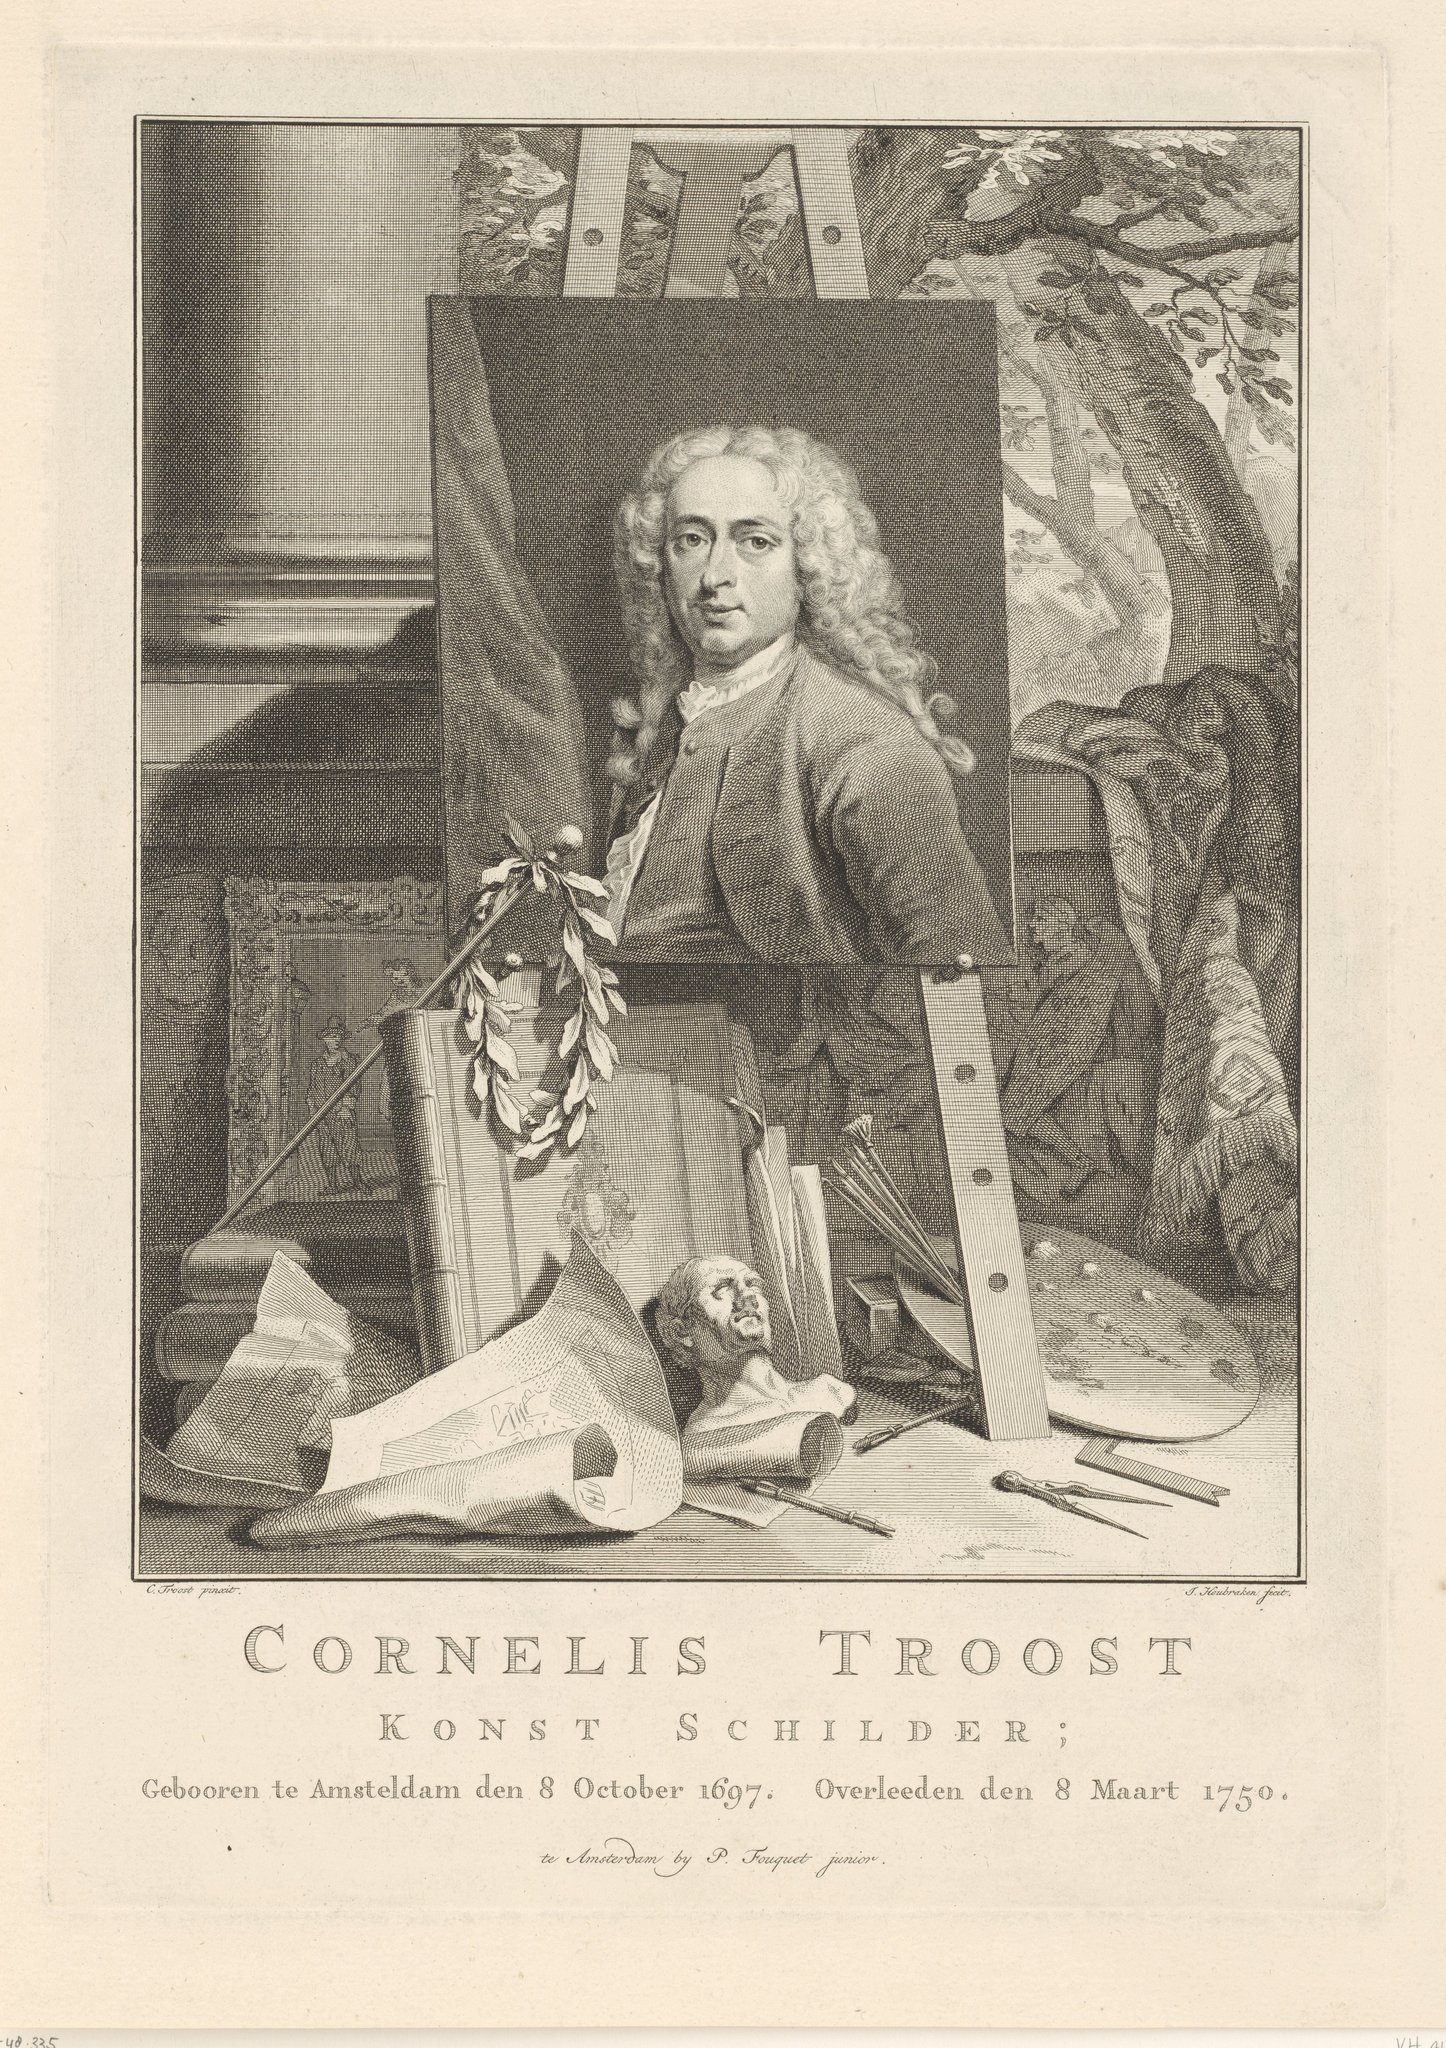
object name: print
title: Portret van Cornelis Troost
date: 1760-1780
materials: paper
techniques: engraving, etching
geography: amsterdam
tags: amsterdam, painter, print maker, draughtsman, cornelis troost, historical persons, portrait, self-portrait of painter, tools, implements of painter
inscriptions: collector's mark: Lugt 240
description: Portret naar links van de schilder Cornelis Troost. Het schilderij met zijn portret staat op een schildersezel op een bordes en is omringd door de attributen van de schilder- en graveerkunst. Onder de ezel liggen palet en penselen, een gebeeldhouwde kop, tekenstiften, boeken en tekeningen. Links staat de schildersstok, waaraan een lauwerkrans hangt. Daarachter een schilderij in lijst. In de achtergrond een doorkijk naar een landschap. Onder de voorstelling de naam en gegevens van de geportretteerde in drie regels in het Nederlands.